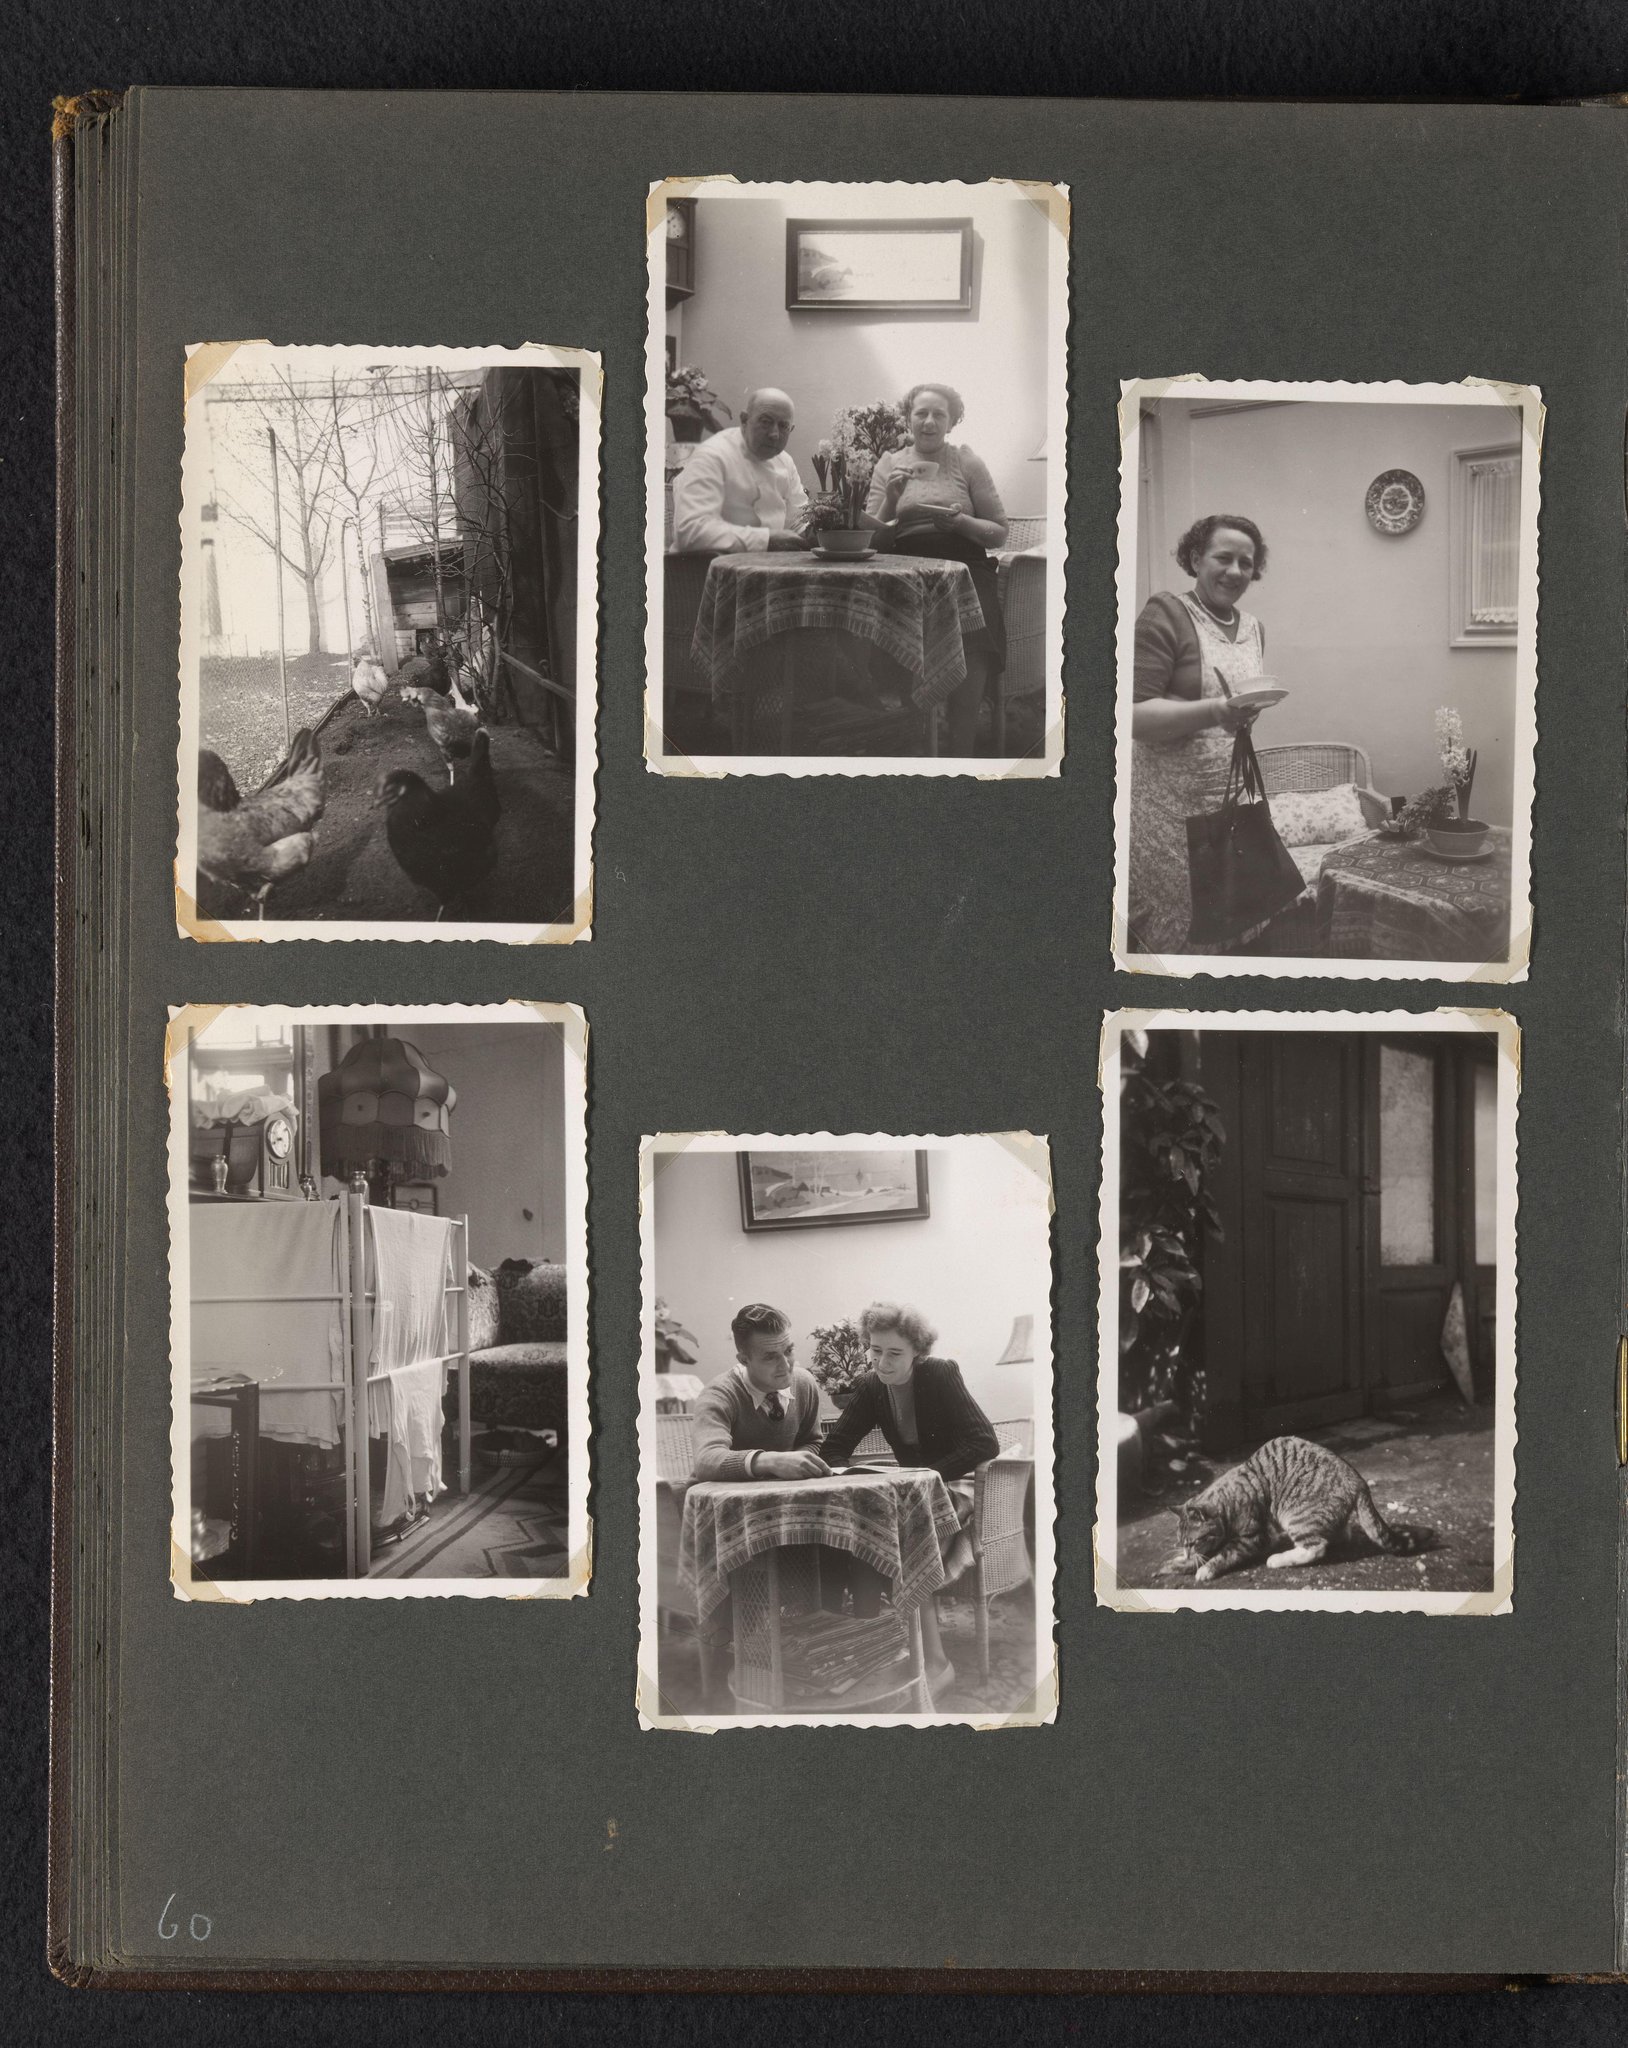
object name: photograph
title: Familie of vrienden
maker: Anonymous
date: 1950-1951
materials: cardboard, photographic support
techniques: gelatin silver print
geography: netherlands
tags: cat, communal rooms, fowl (cock, hen, chicken, etc.), family life at home, netherlands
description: Albumblad met zes foto's van familie of vrienden, thuis in de kamer, de kippen en de poes. Onderdeel van het fotoalbum 'Mijn jaren in Indië' met foto's over de militaire acties in Nederlands-Indië.